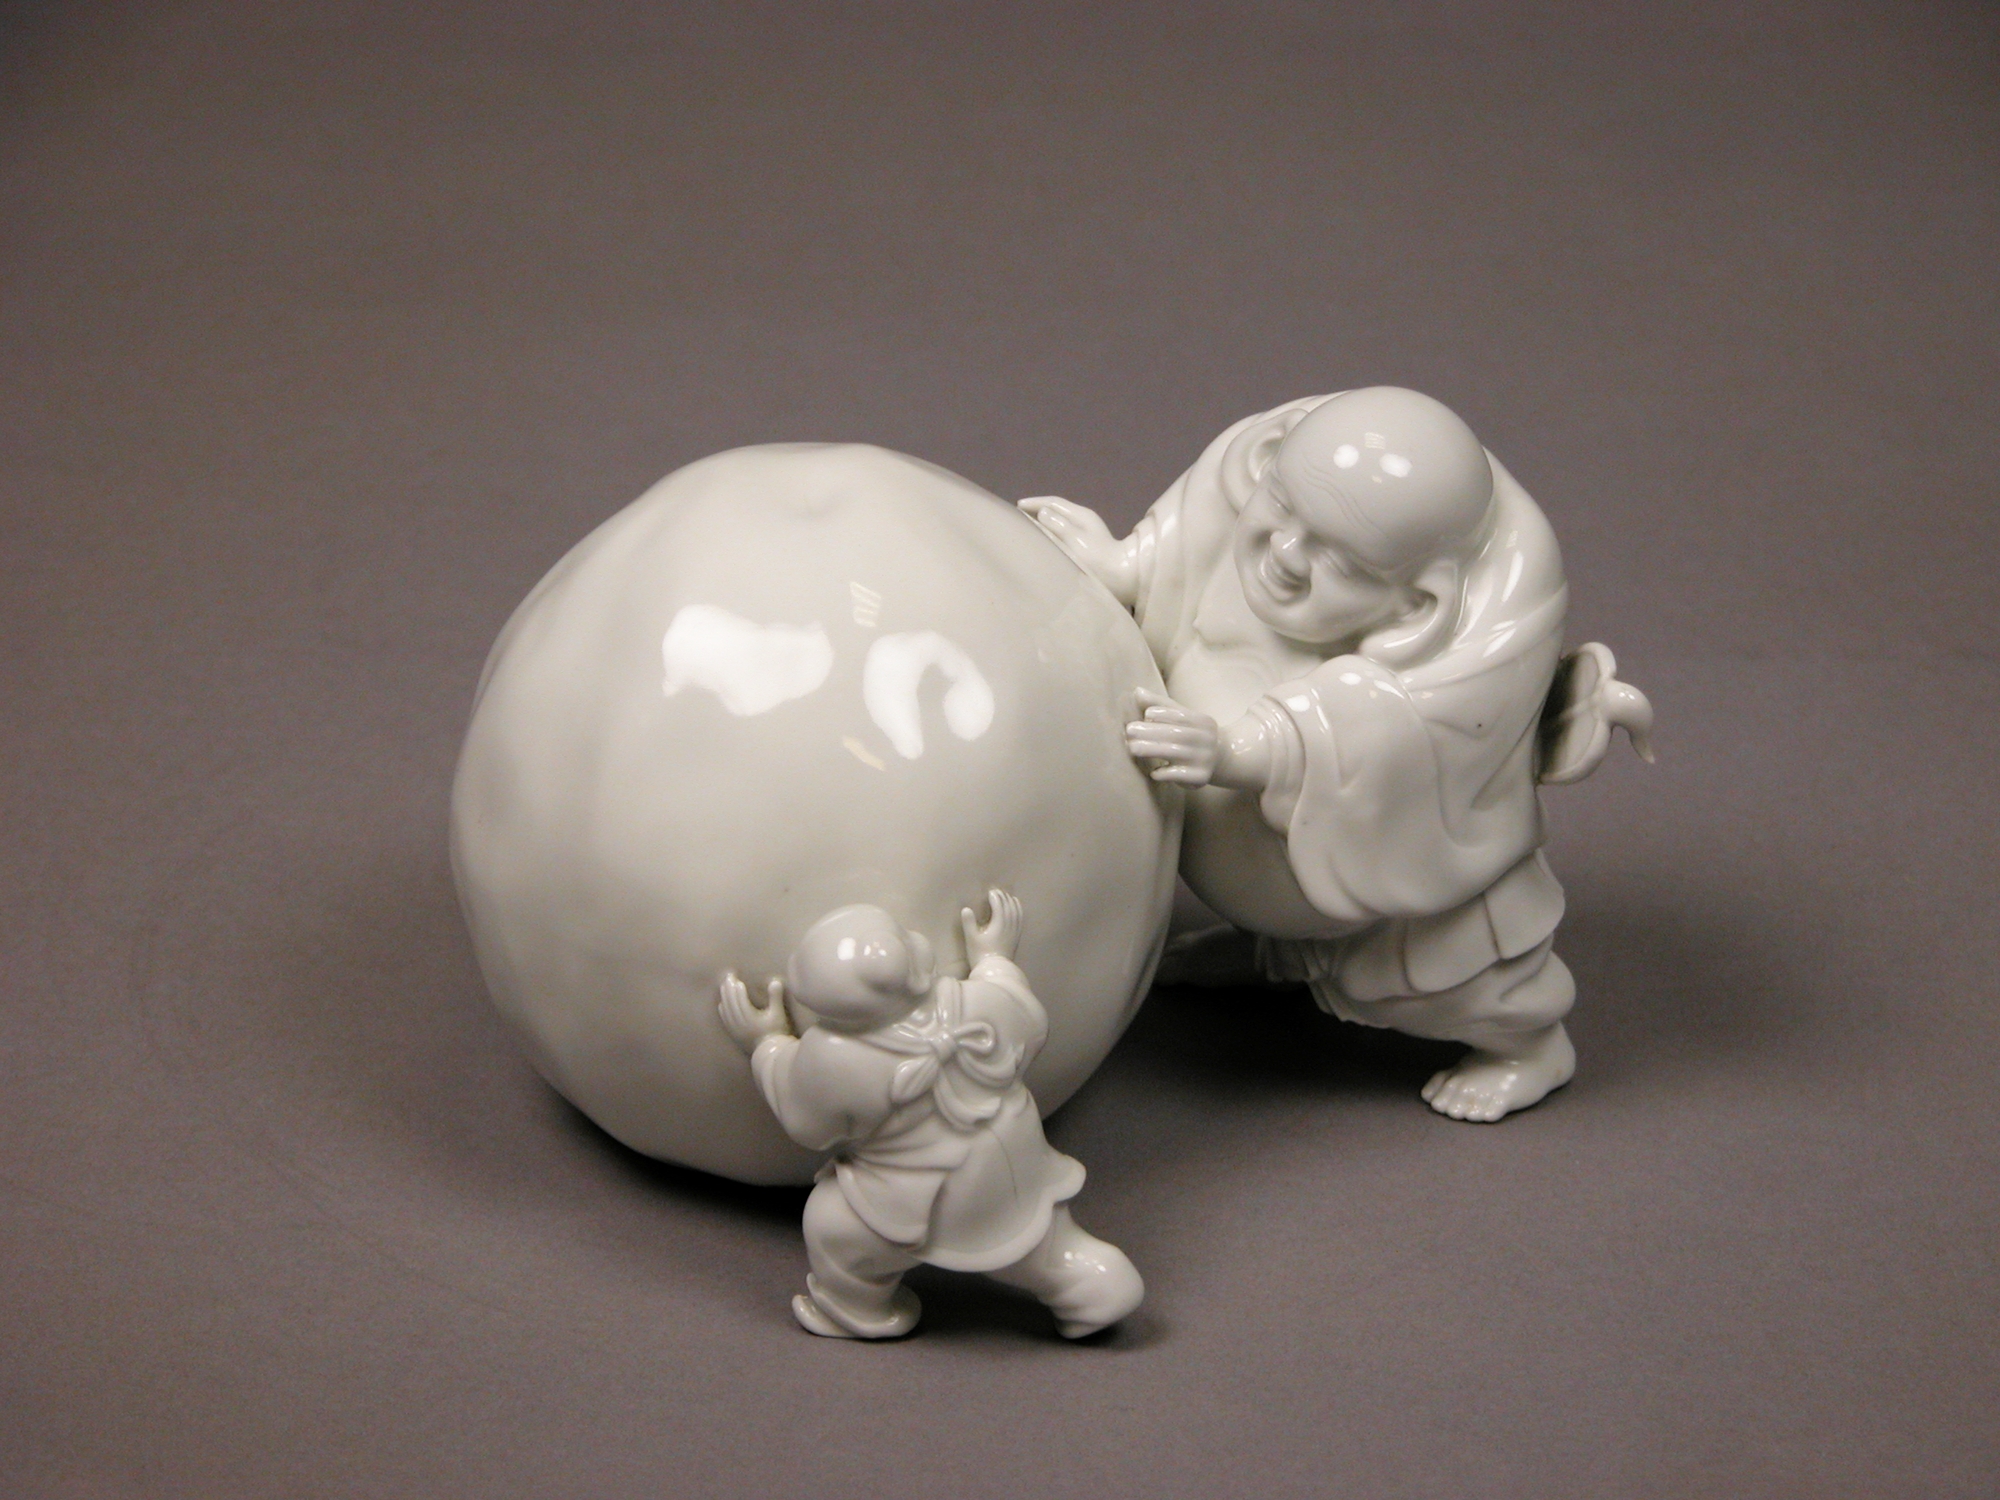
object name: alcove ornament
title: Snowball Pushed by Hotei and a Child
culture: japanese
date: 1834-1866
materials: porcelain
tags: boys,men